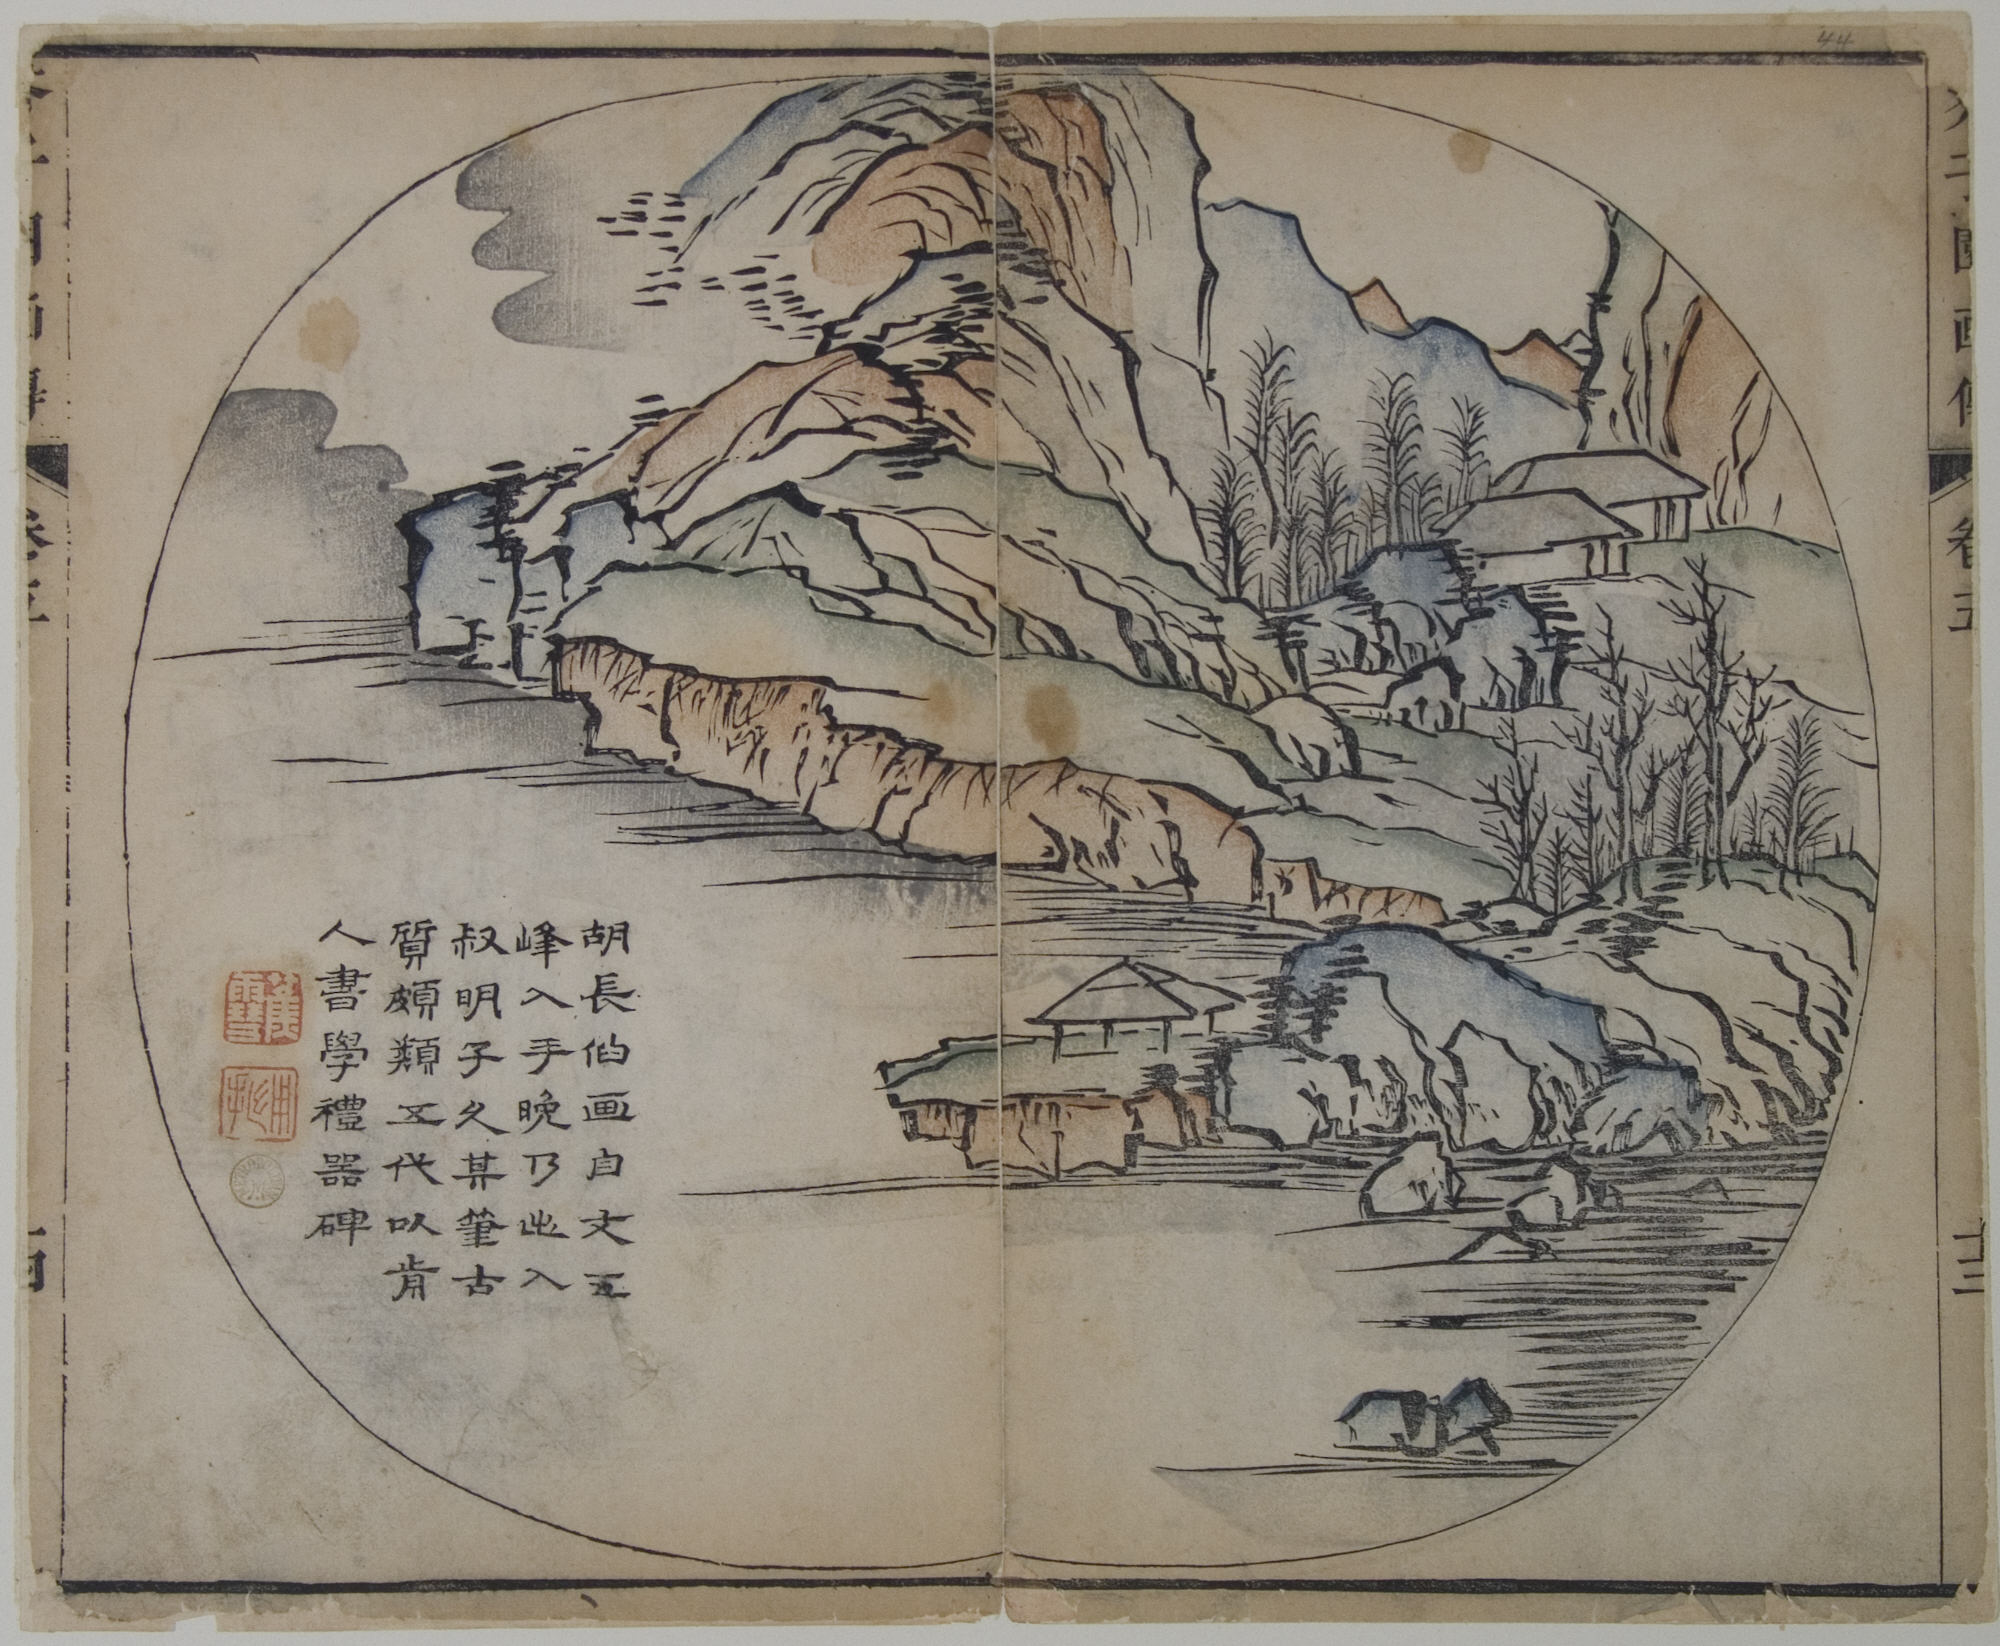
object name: print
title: Page from the Mustard Seed Garden Manual of Painting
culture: chinese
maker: wang gai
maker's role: artist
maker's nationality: chinese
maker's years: 1645-1710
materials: ink, paper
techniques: woodblock print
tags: mountains,trees